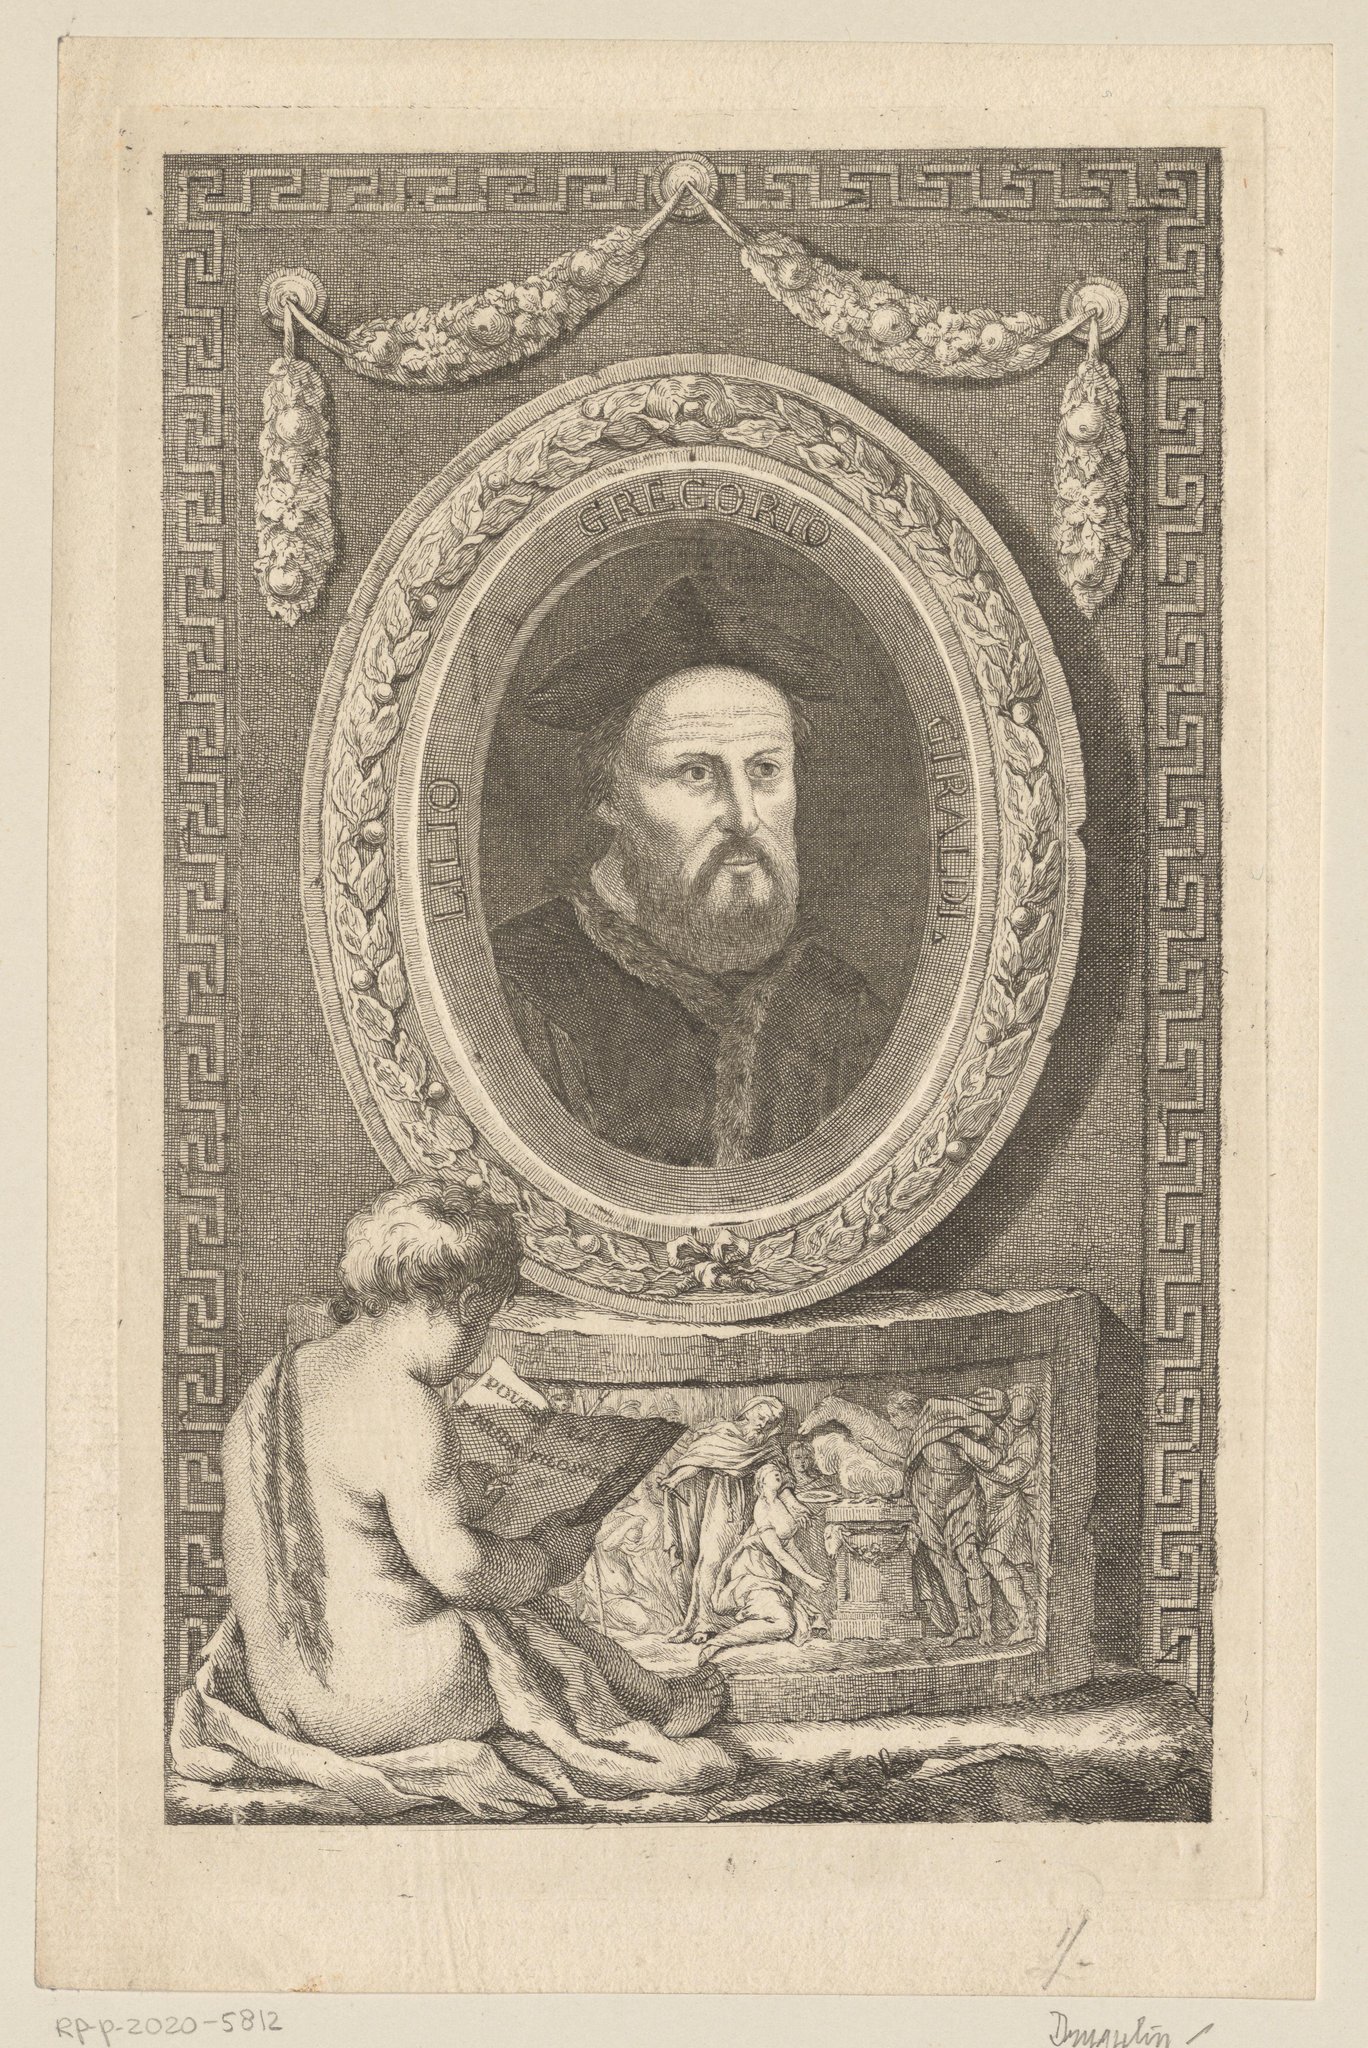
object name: print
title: Portret van Giglio Gregorio Giraldi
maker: Anonymous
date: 1700-1800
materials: paper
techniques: engraving, etching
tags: historical persons, writer, poet, author